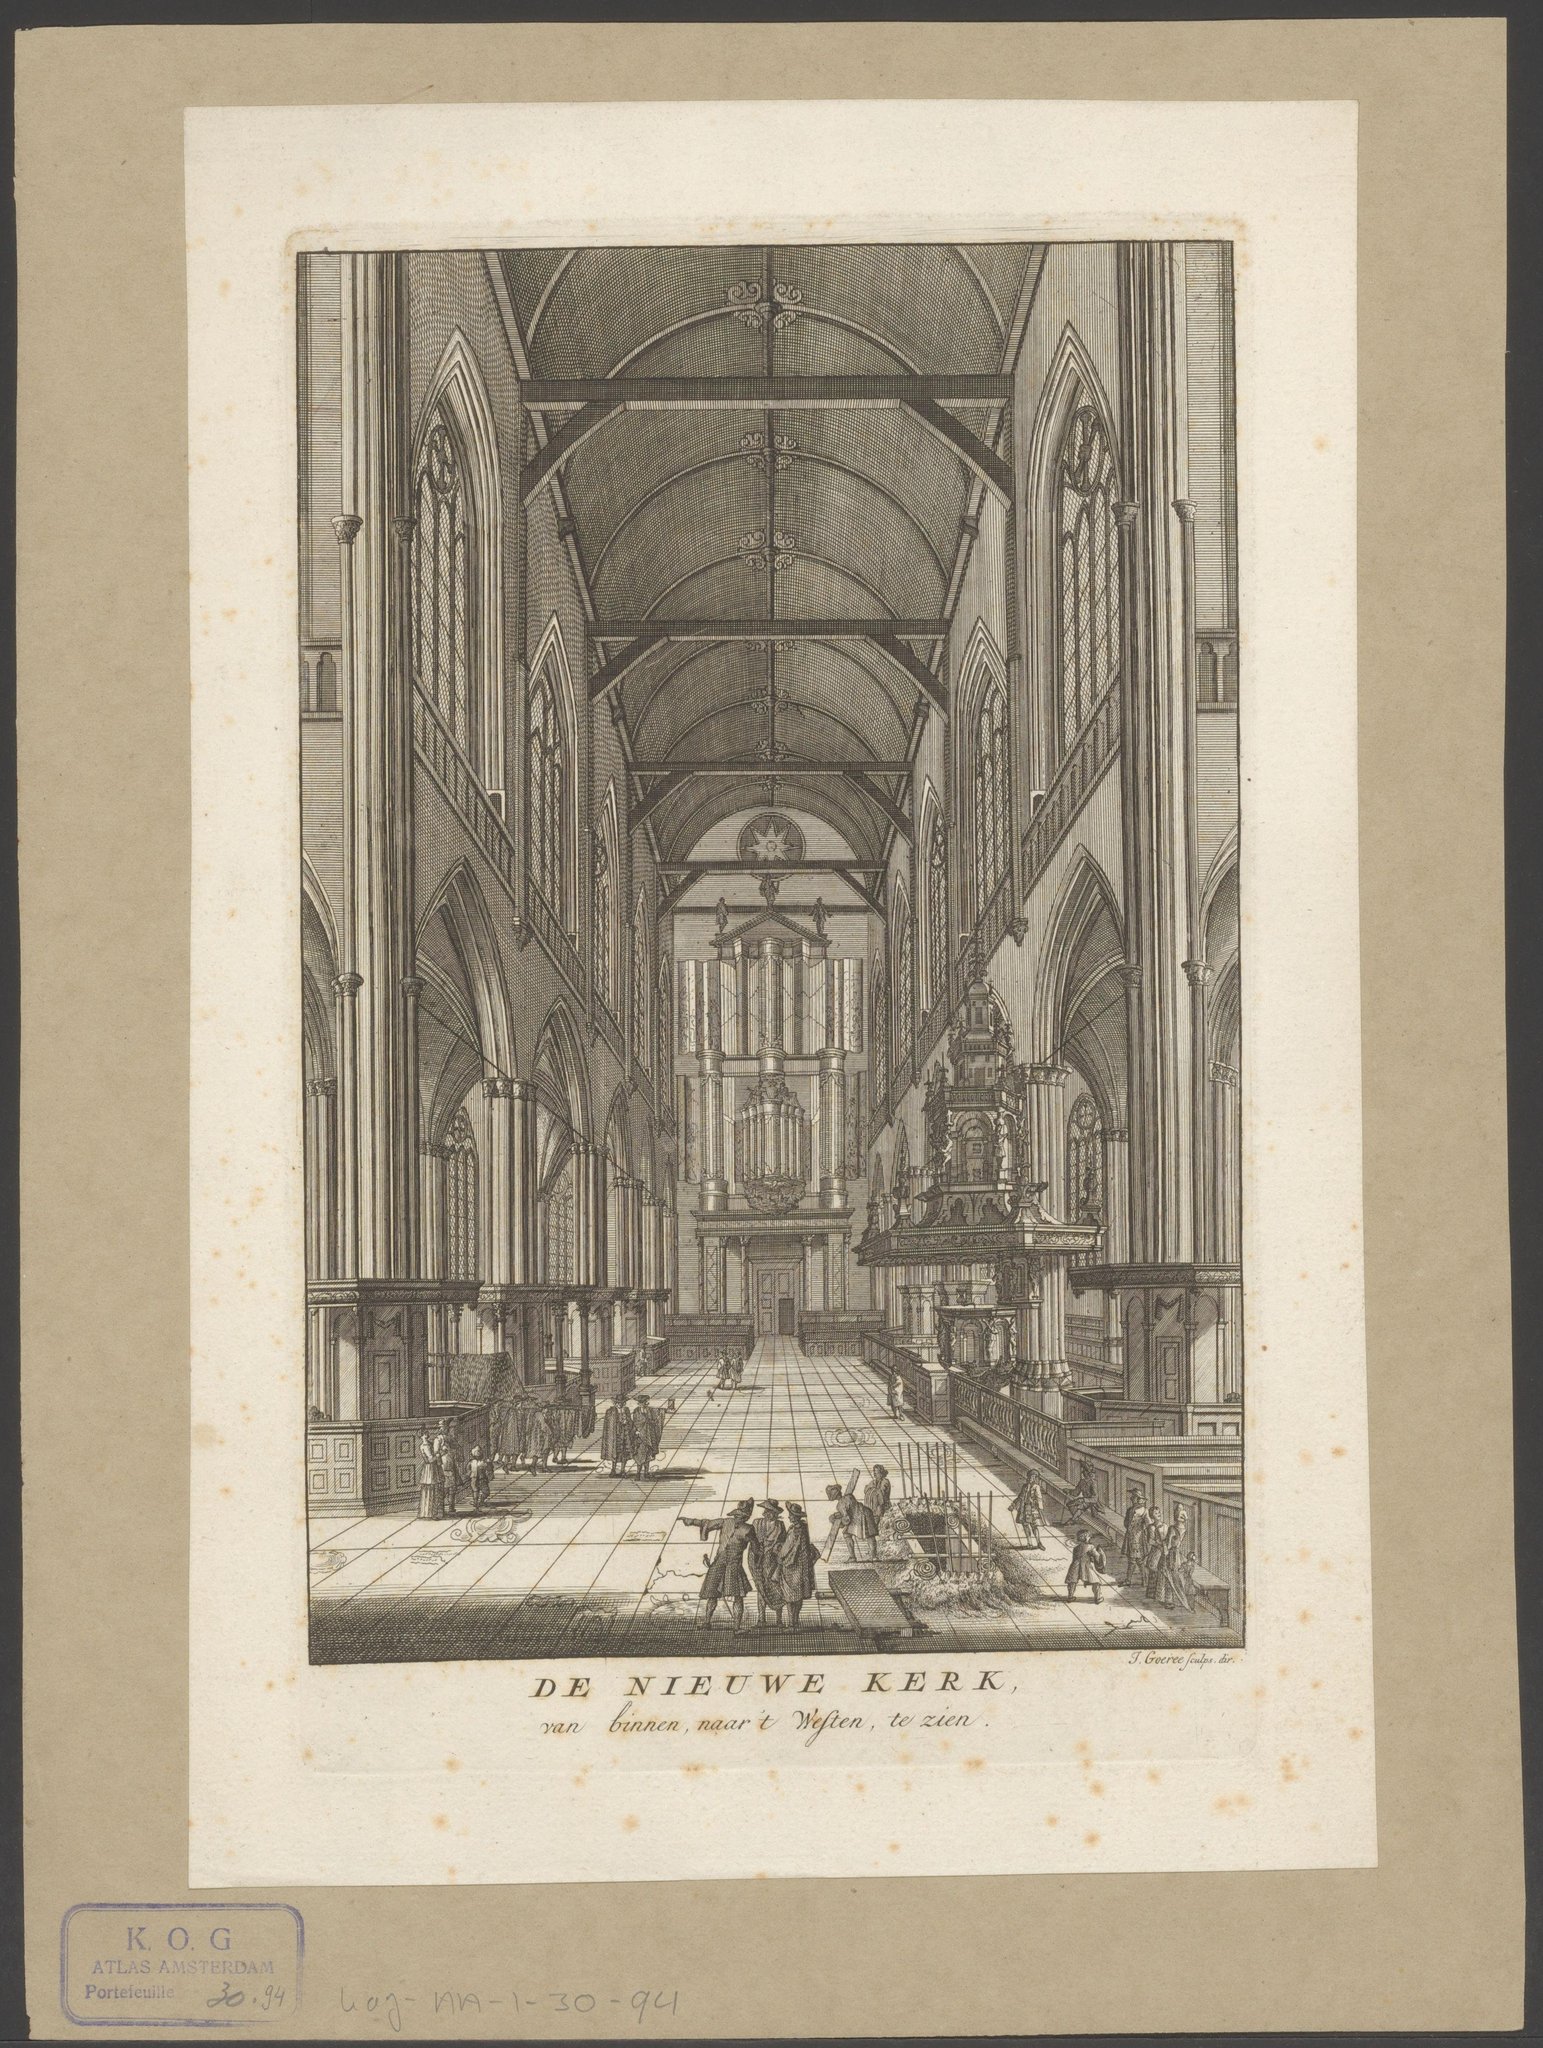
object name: print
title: De Nieuwe Kerk, van binnen, naar 't Westen, te zien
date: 1765-1782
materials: paper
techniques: engraving, etching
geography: amsterdam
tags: interior of church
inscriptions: collector's mark: Lugt 1641b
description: Prent mogelijk uit: Wagenaar, Jan. Amsterdam, in zyne opkomst, aanwas, geschiedenissen (…). Amsterdam: Isaak Tirion, 1765, dl. 2. Of uit: Of uit: Verzameling der fraaiste gezigten van Amsterdam in negen en zeventig afbeeldingen. Amsterdam en Harlingen: Petrus Conradi en Volkert van der Plaats, 1782.